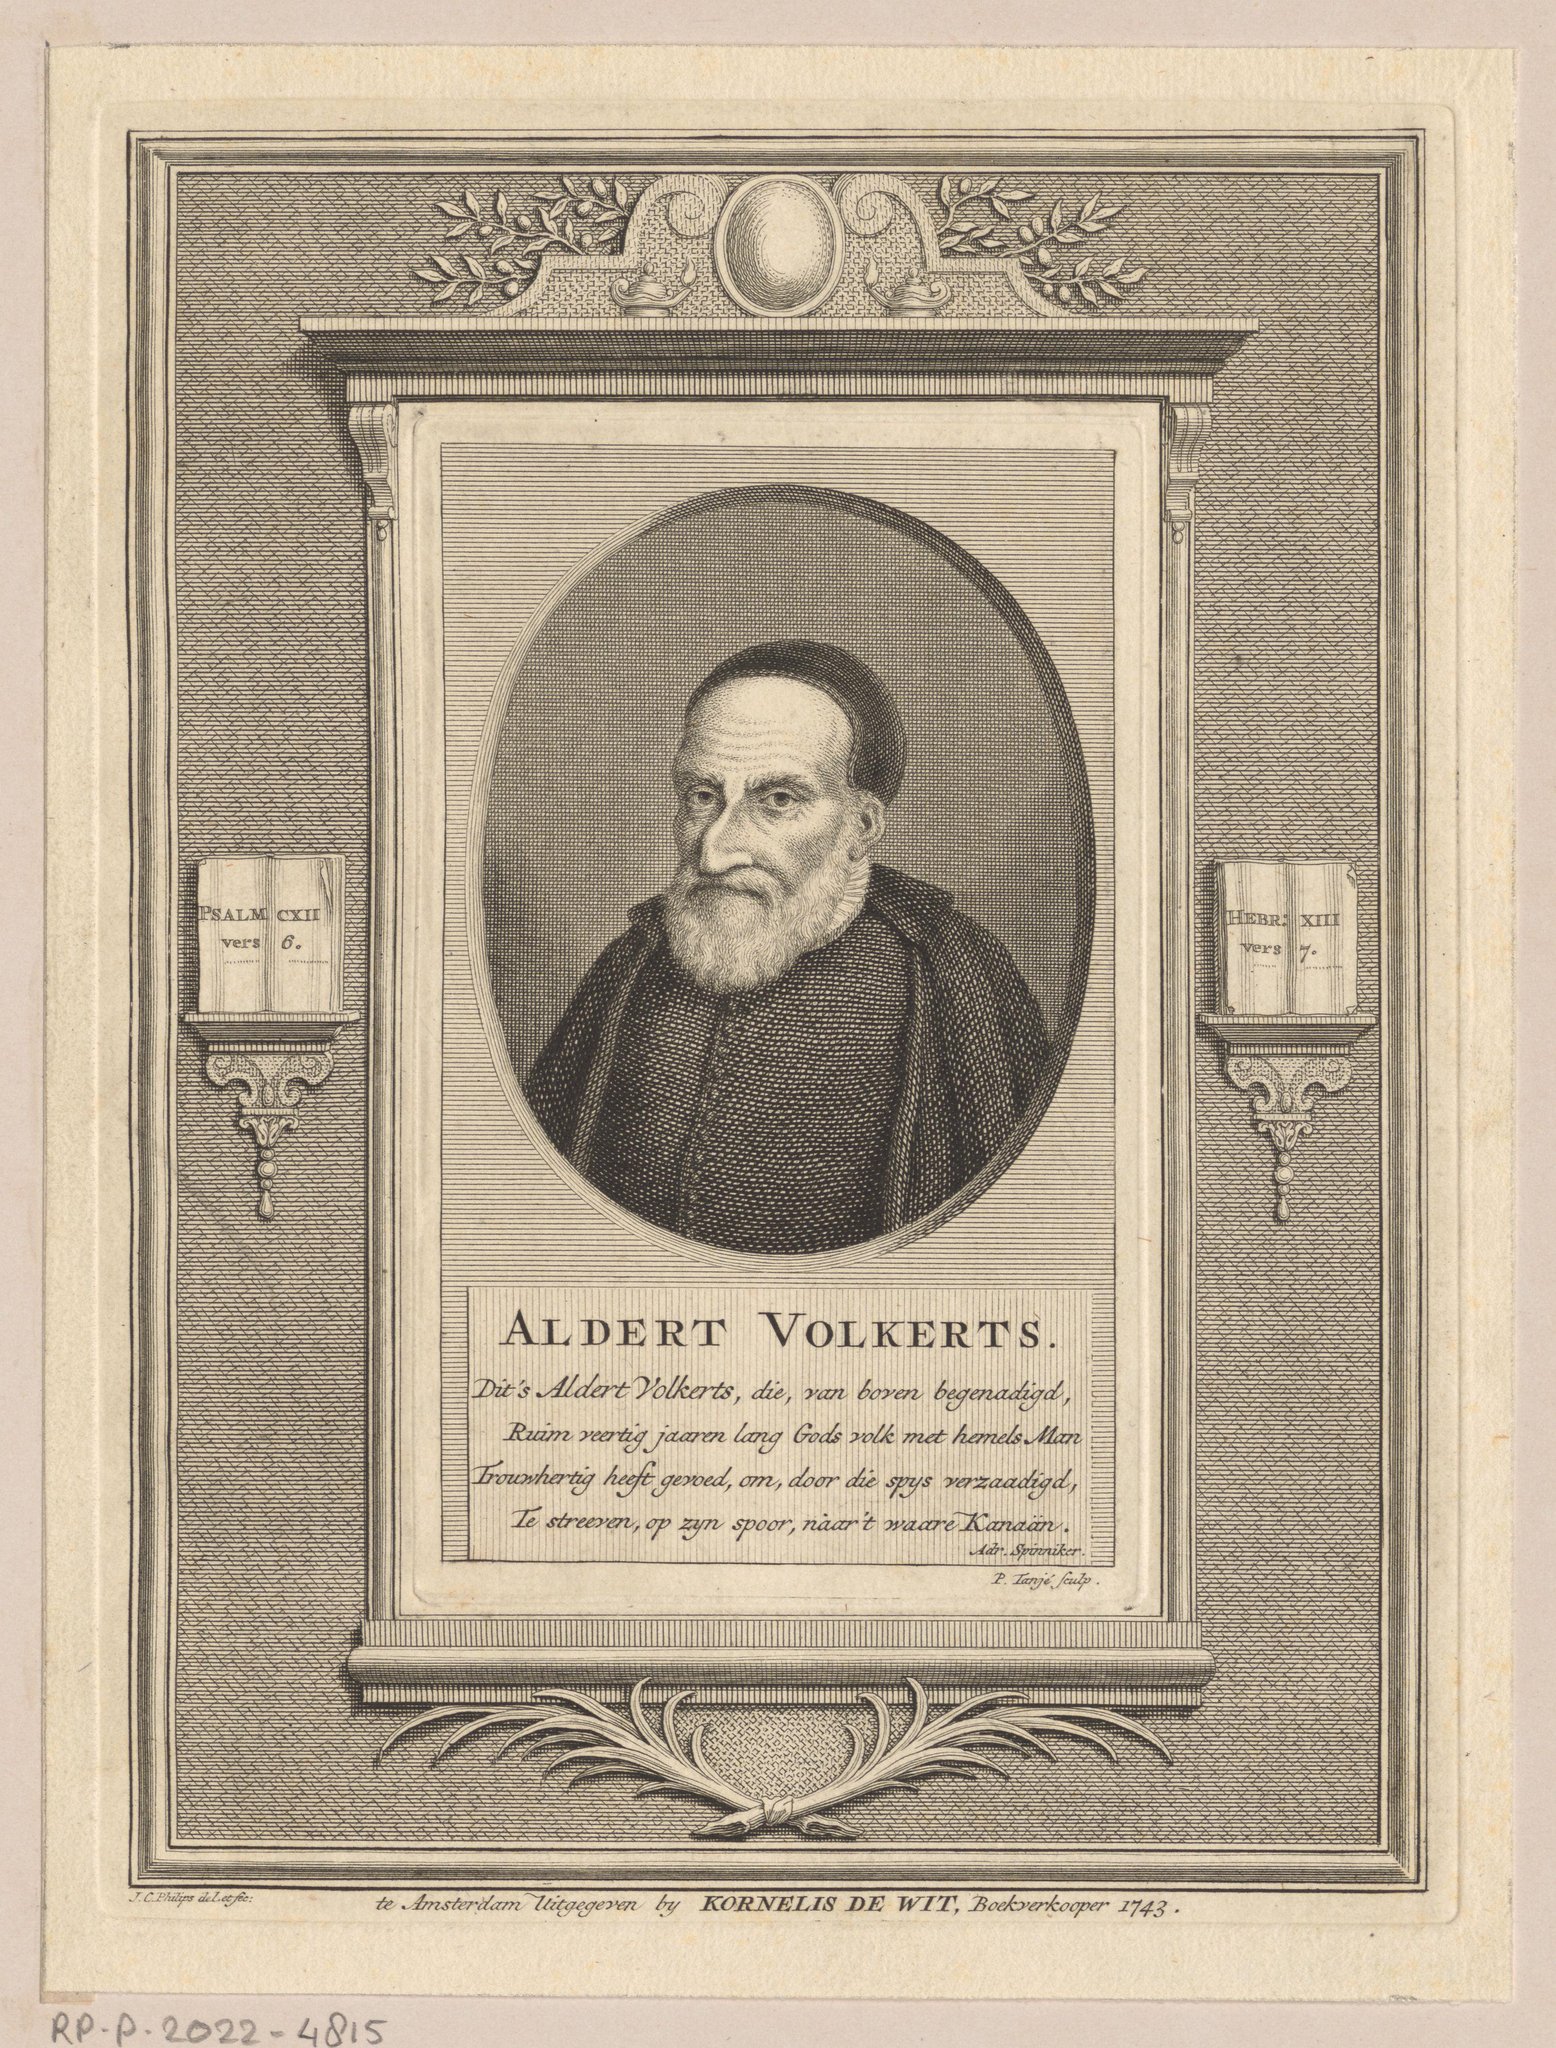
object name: print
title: Portret van Aldert Volkerts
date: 1743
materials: paper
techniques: engraving, etching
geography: amsterdam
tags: theologian, historical persons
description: Prent waarschijnlijk uit: Verzaameling van de afbeeldingen van veele voornaame mannen en leeraaren, die (...) het leeraars ampt onder de doopsgezinde christenen bediend hebben. Amsterdam: Kornelis de Wit, 1743. Prent zonder omlijsting gebruikt in: Schijn, Hermannus. Uitvoeriger verhandeling van de Geschiedenisse der mennoniten. Amsterdam: Kornelis de Wit, 1744. Ook gebruikt in: Maatschoen, Gerardus. Aanhangzel, dienende tot een vervolg, of derde deel van de Geschiedenisse der mennoniten. Amsterdam: Kornelis de Wit, 1745.